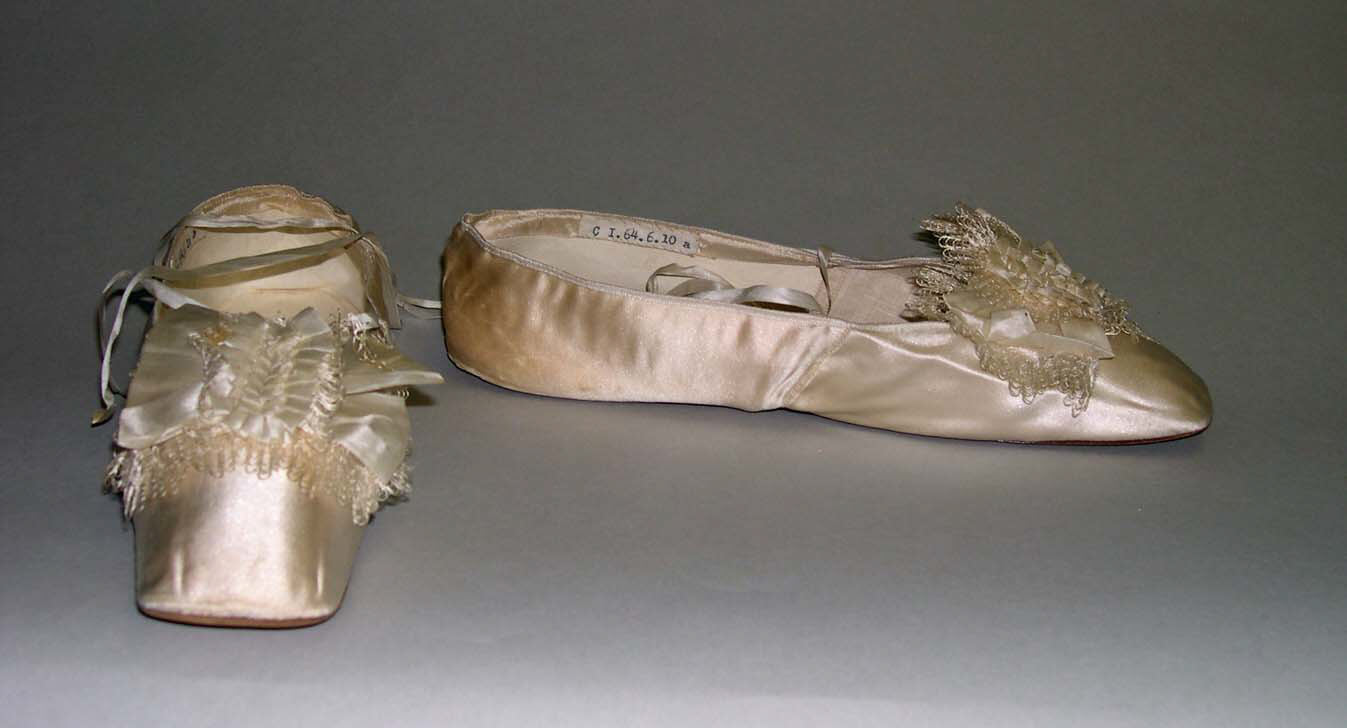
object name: slipper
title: Slippers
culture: european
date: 1840-1859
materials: silk